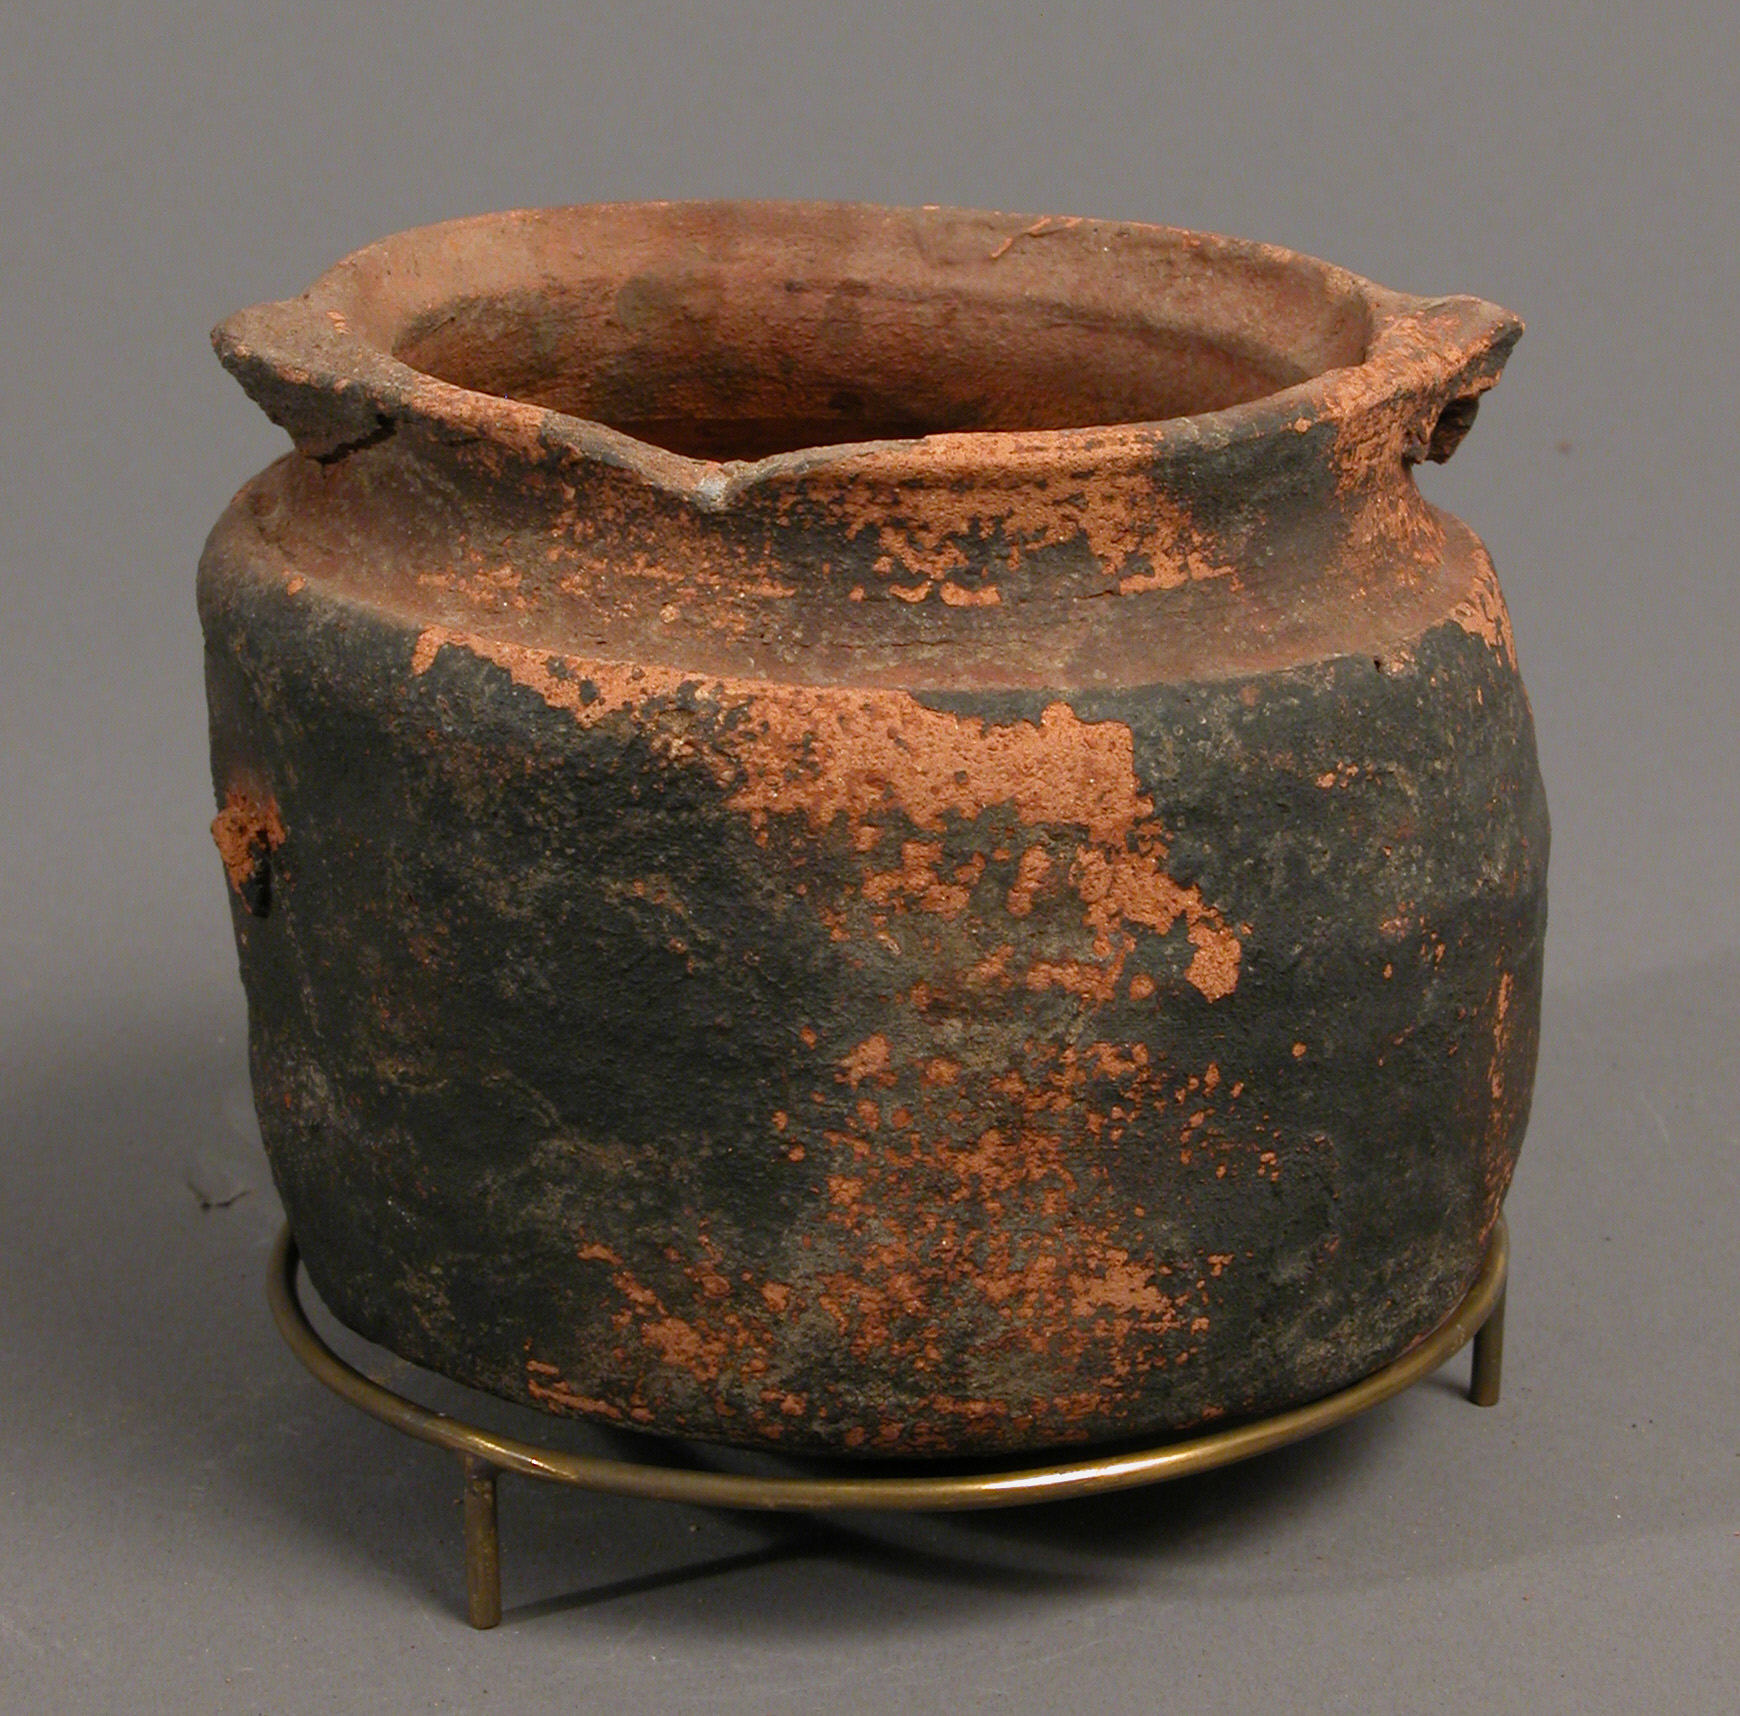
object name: pot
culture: coptic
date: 301-700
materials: earthenware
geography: egypt